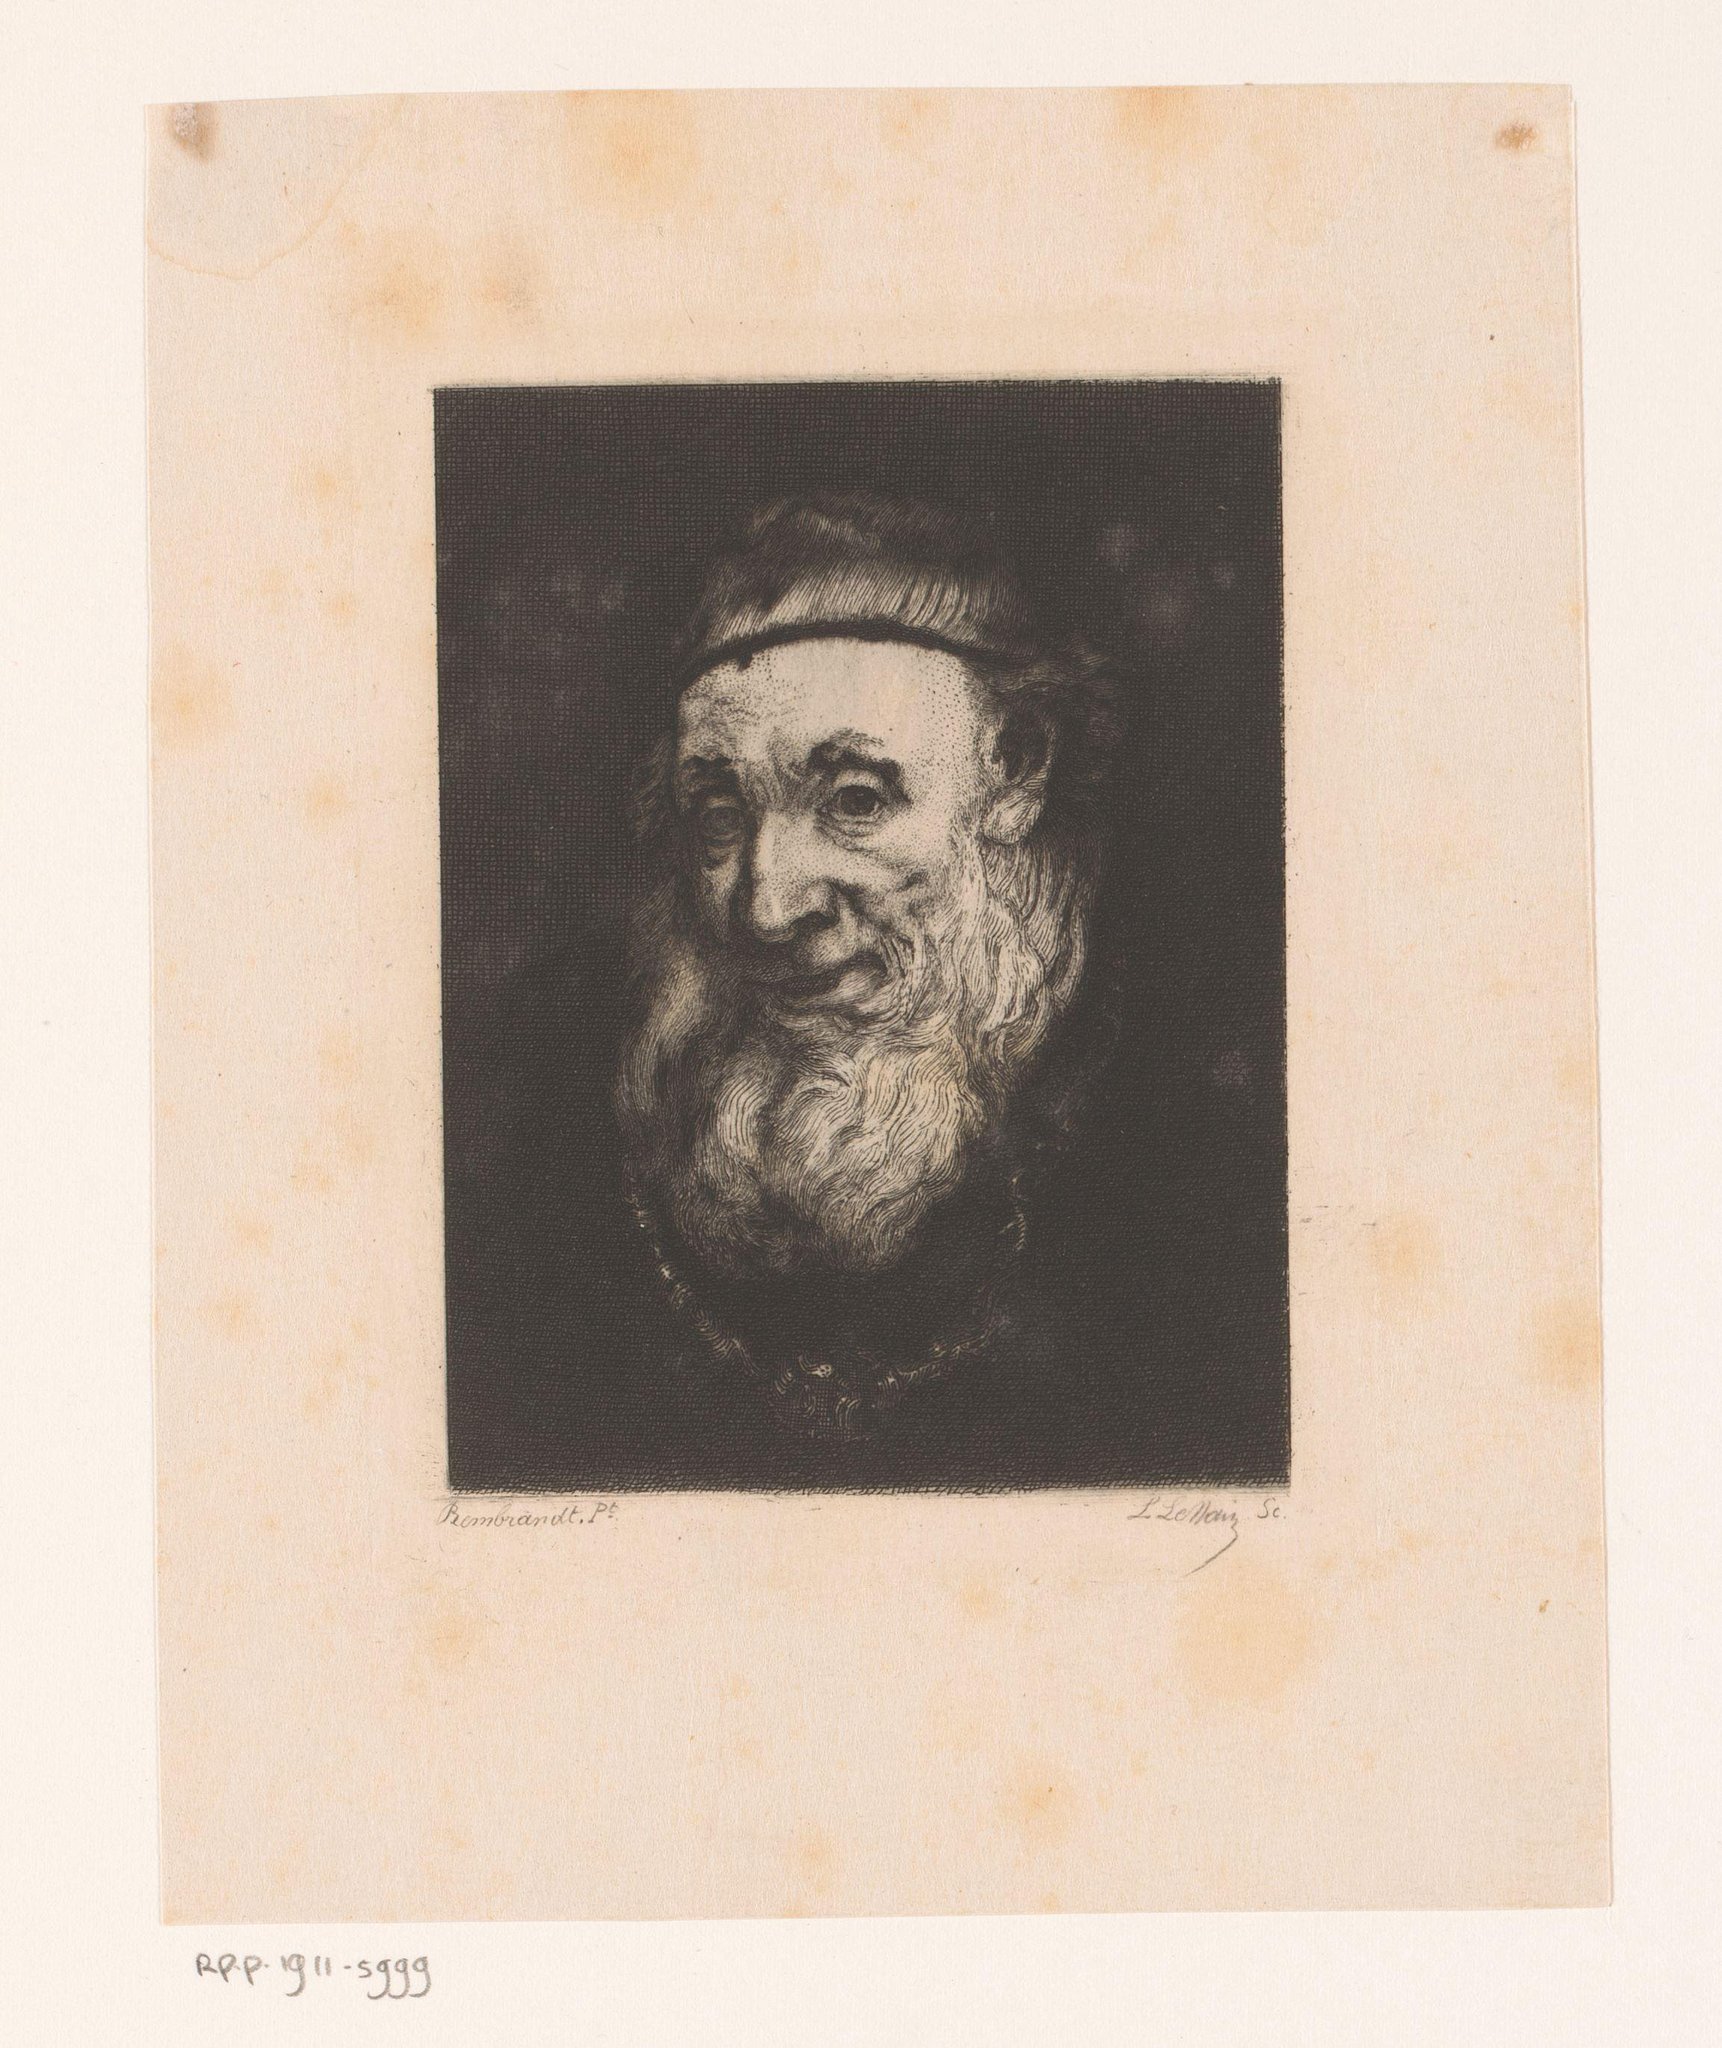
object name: print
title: Kop van een grijsaard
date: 1861-1911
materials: paper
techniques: drypoint, etching, intaglio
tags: old man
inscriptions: collector's mark: Lugt 2228